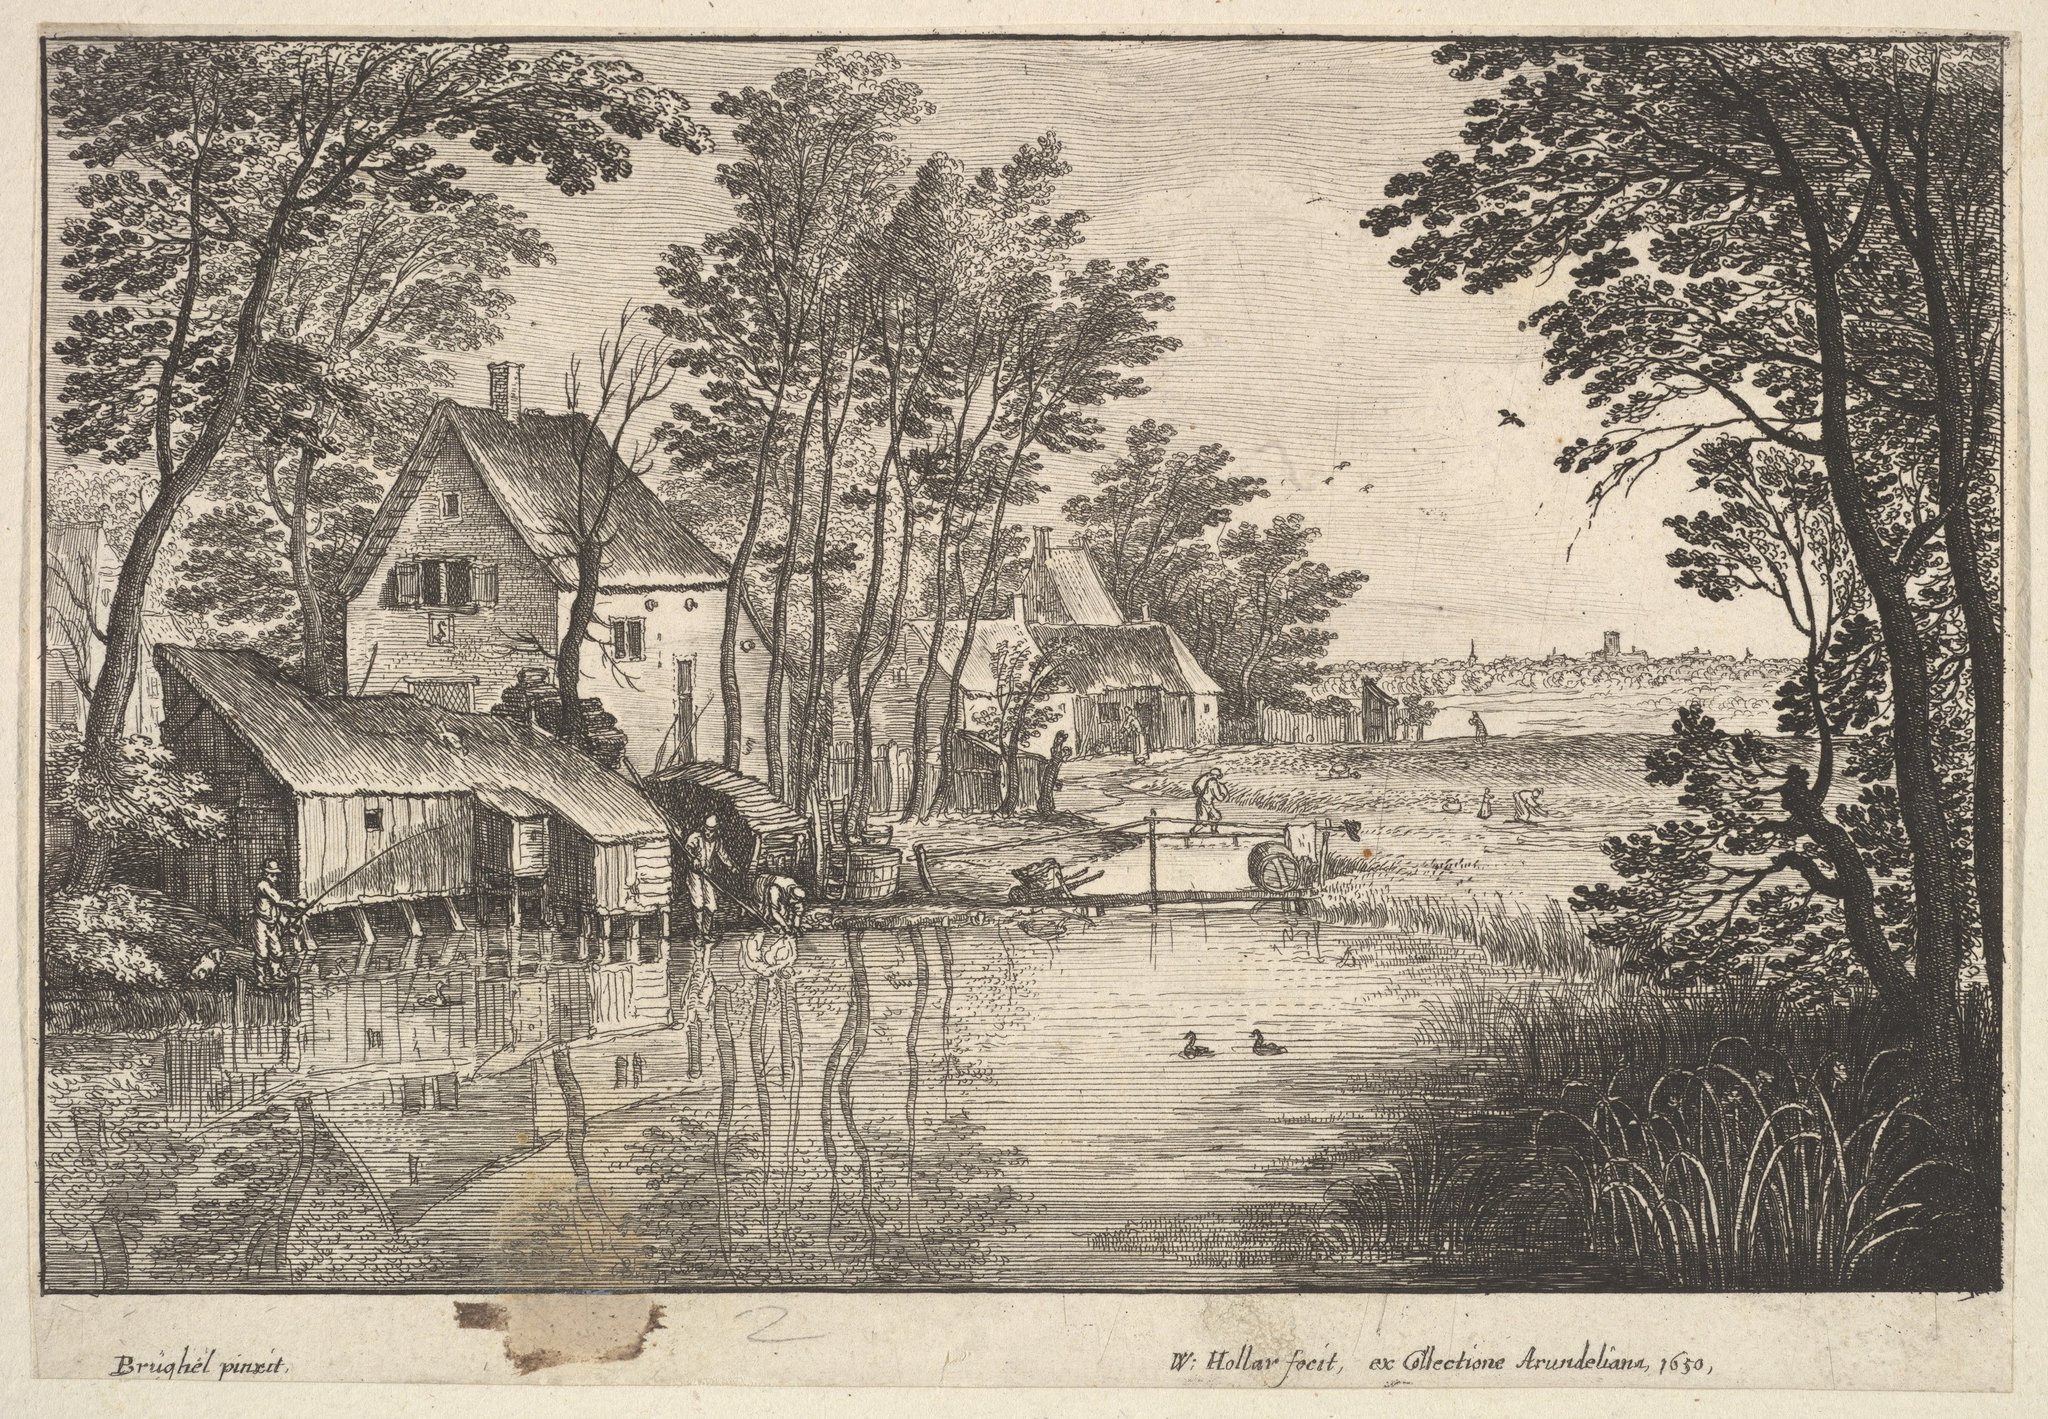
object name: print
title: The Angler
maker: wenceslaus hollar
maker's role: artist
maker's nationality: bohemian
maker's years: 1607-1677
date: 1650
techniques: etching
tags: fishing,landscapes